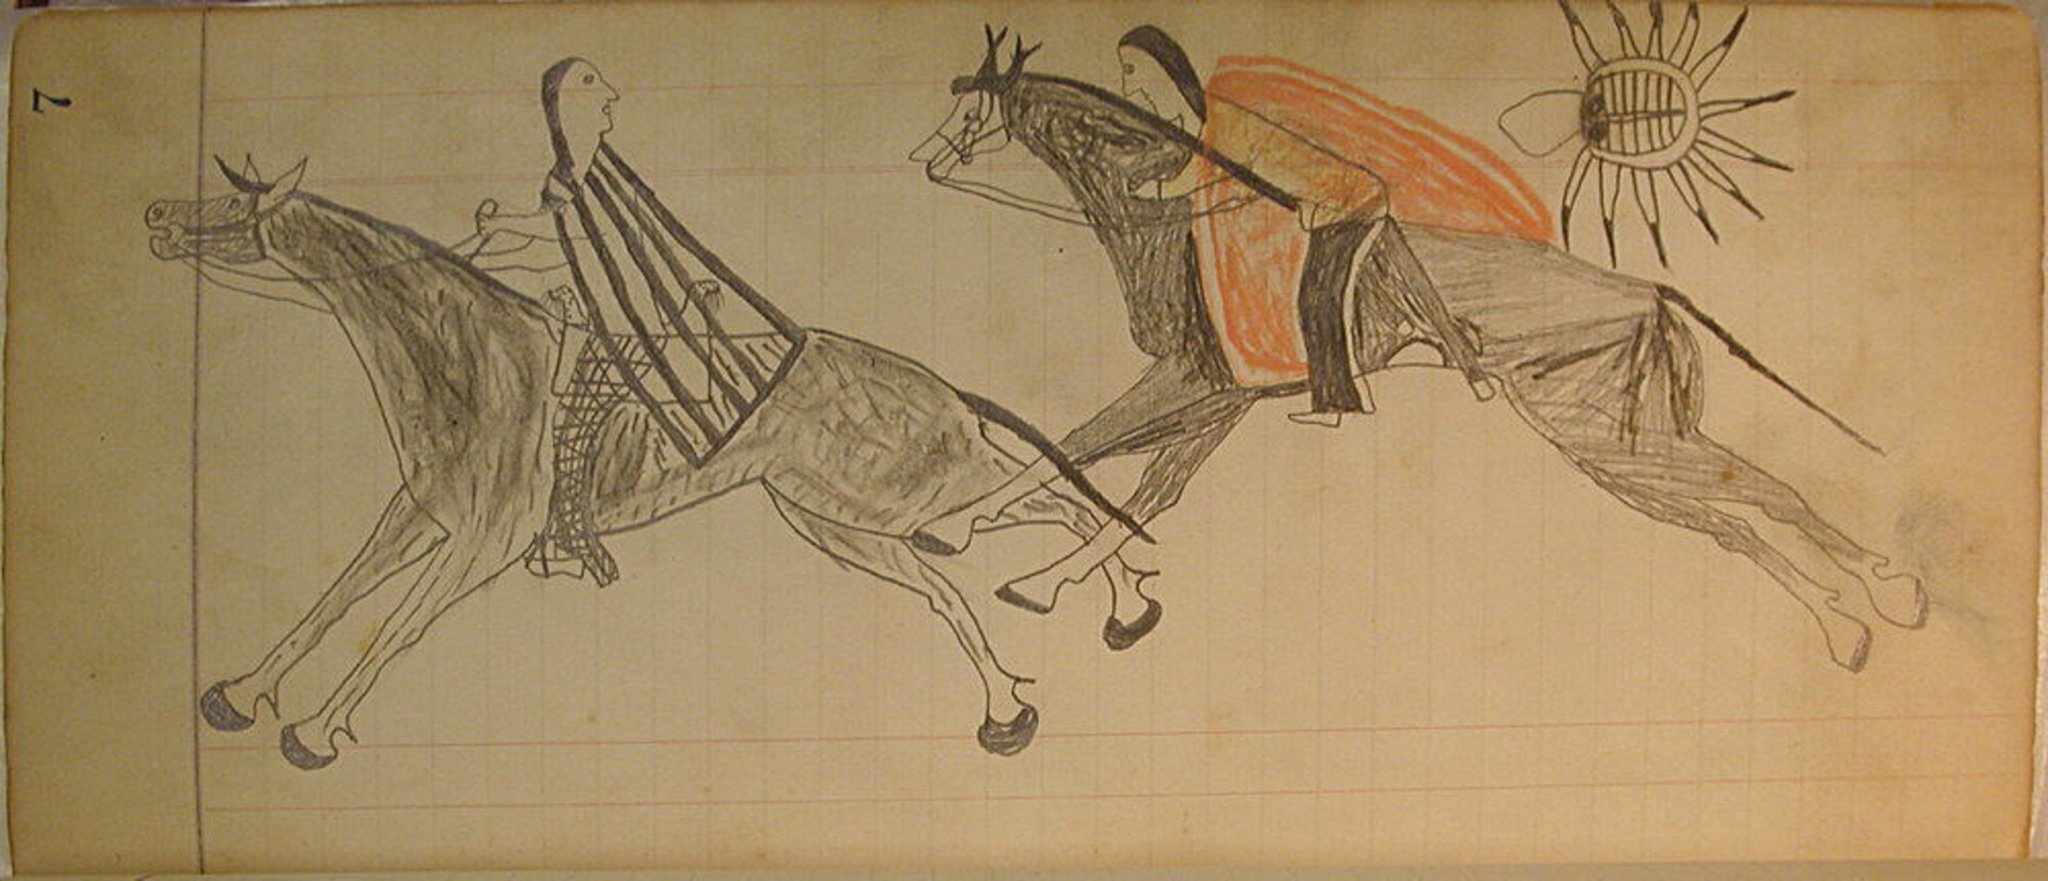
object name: drawing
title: Maffet Ledger: Two Mounted Indians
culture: cheyenne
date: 1874-1881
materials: crayon, graphite, paper, watercolor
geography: united states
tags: human figures,horses